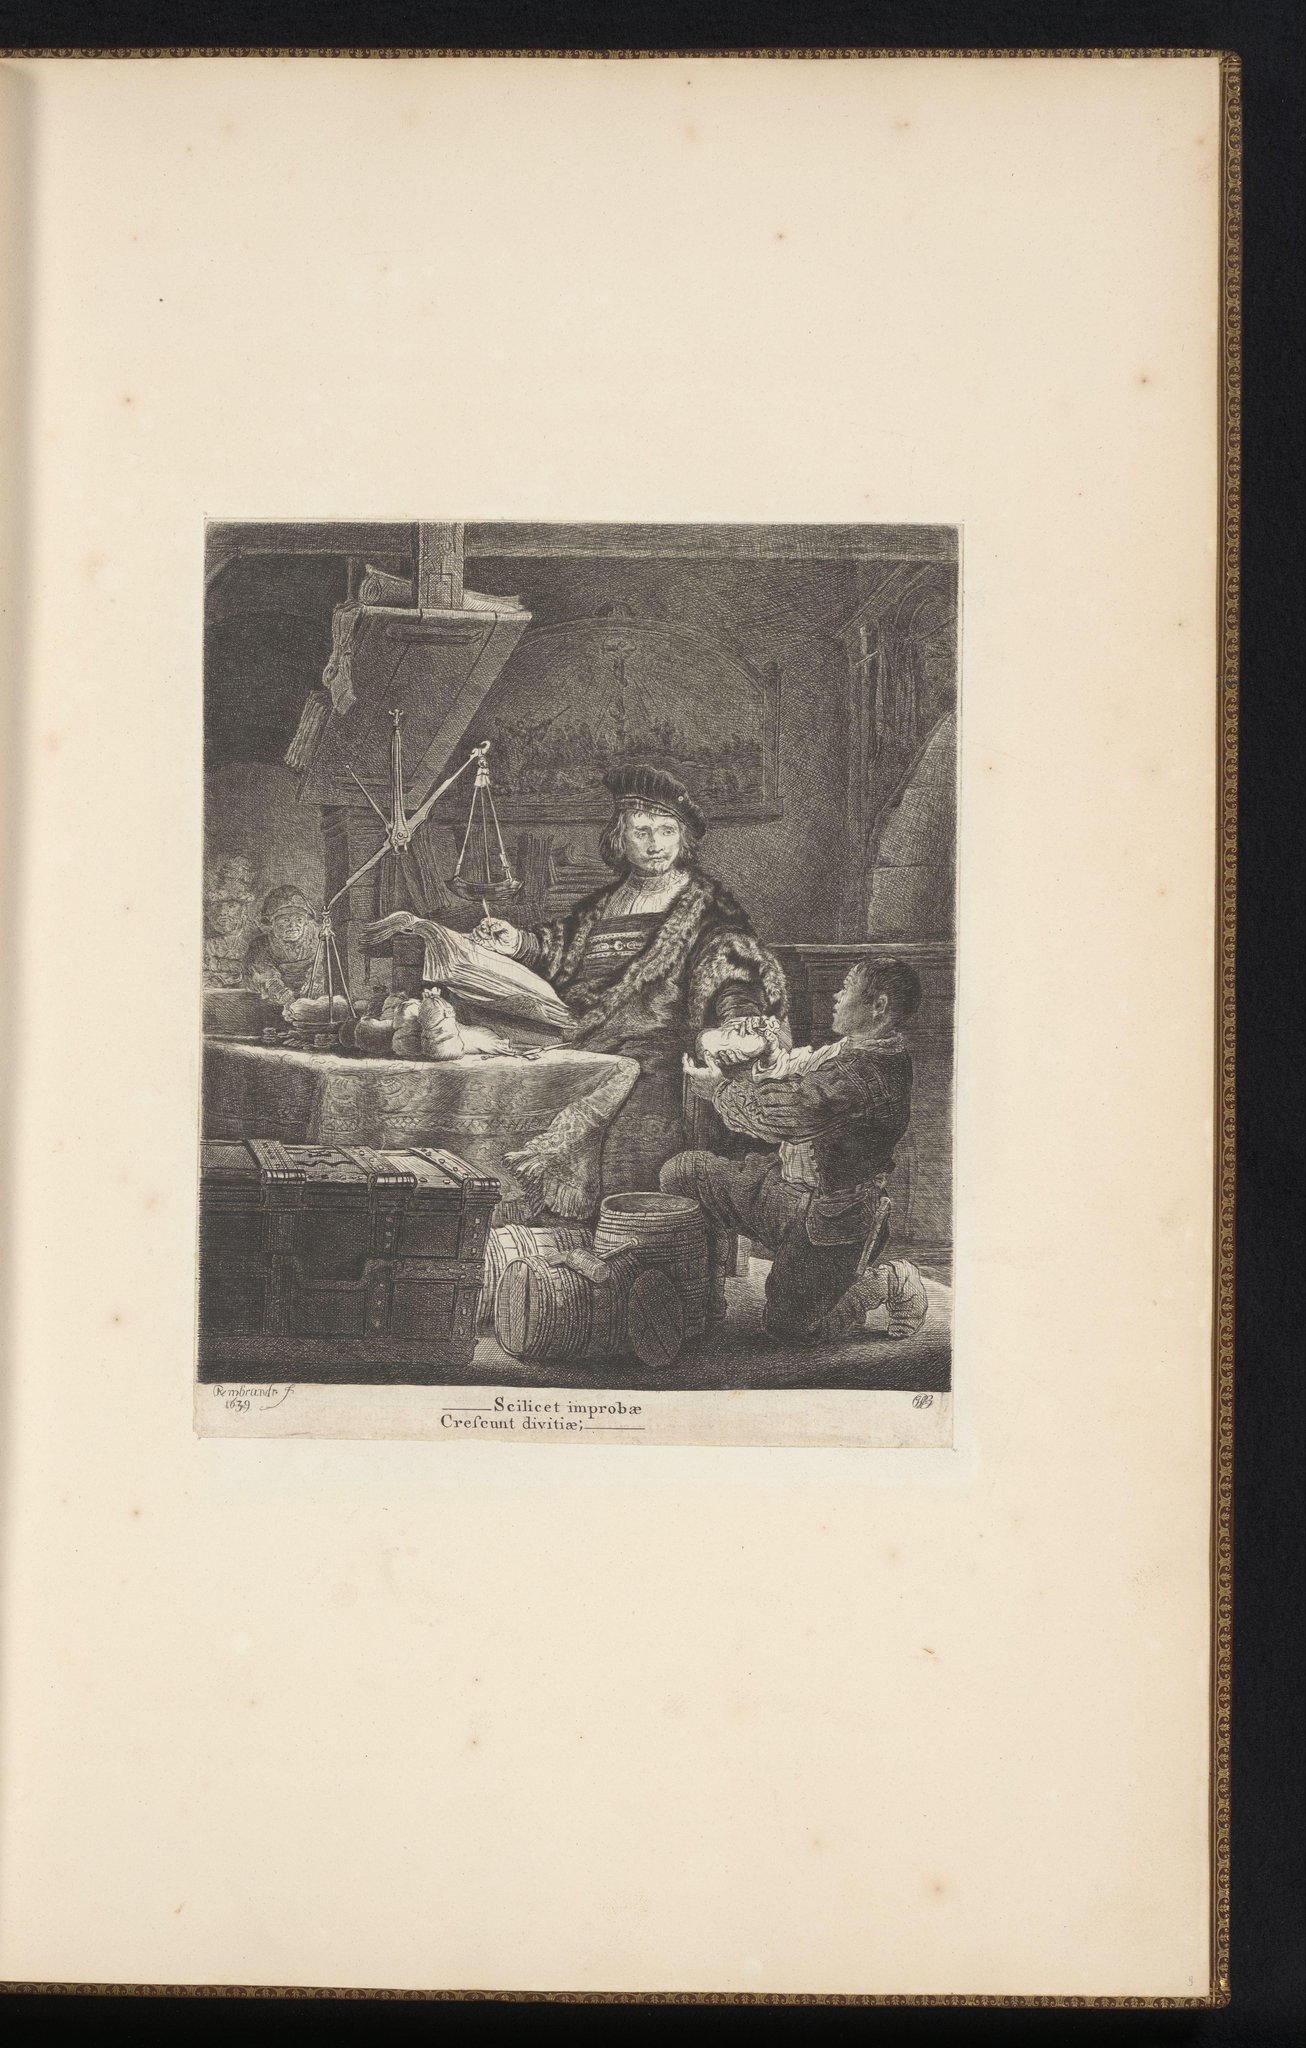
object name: print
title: Goudweger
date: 1753-1810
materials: paper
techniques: drypoint, etching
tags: amsterdam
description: Een goed geklede man zit in een bontmantel en baret aan een tafel, schrijvend in een grootboek. Hij geeft een tas aan een man die naast hem knielt. Op de voorgrond een kist en enkele vaten. Aan de wand hangt een schilderij met een afbeelding van Mozes en de koperen slang. De prent maakt deel uit van een album.